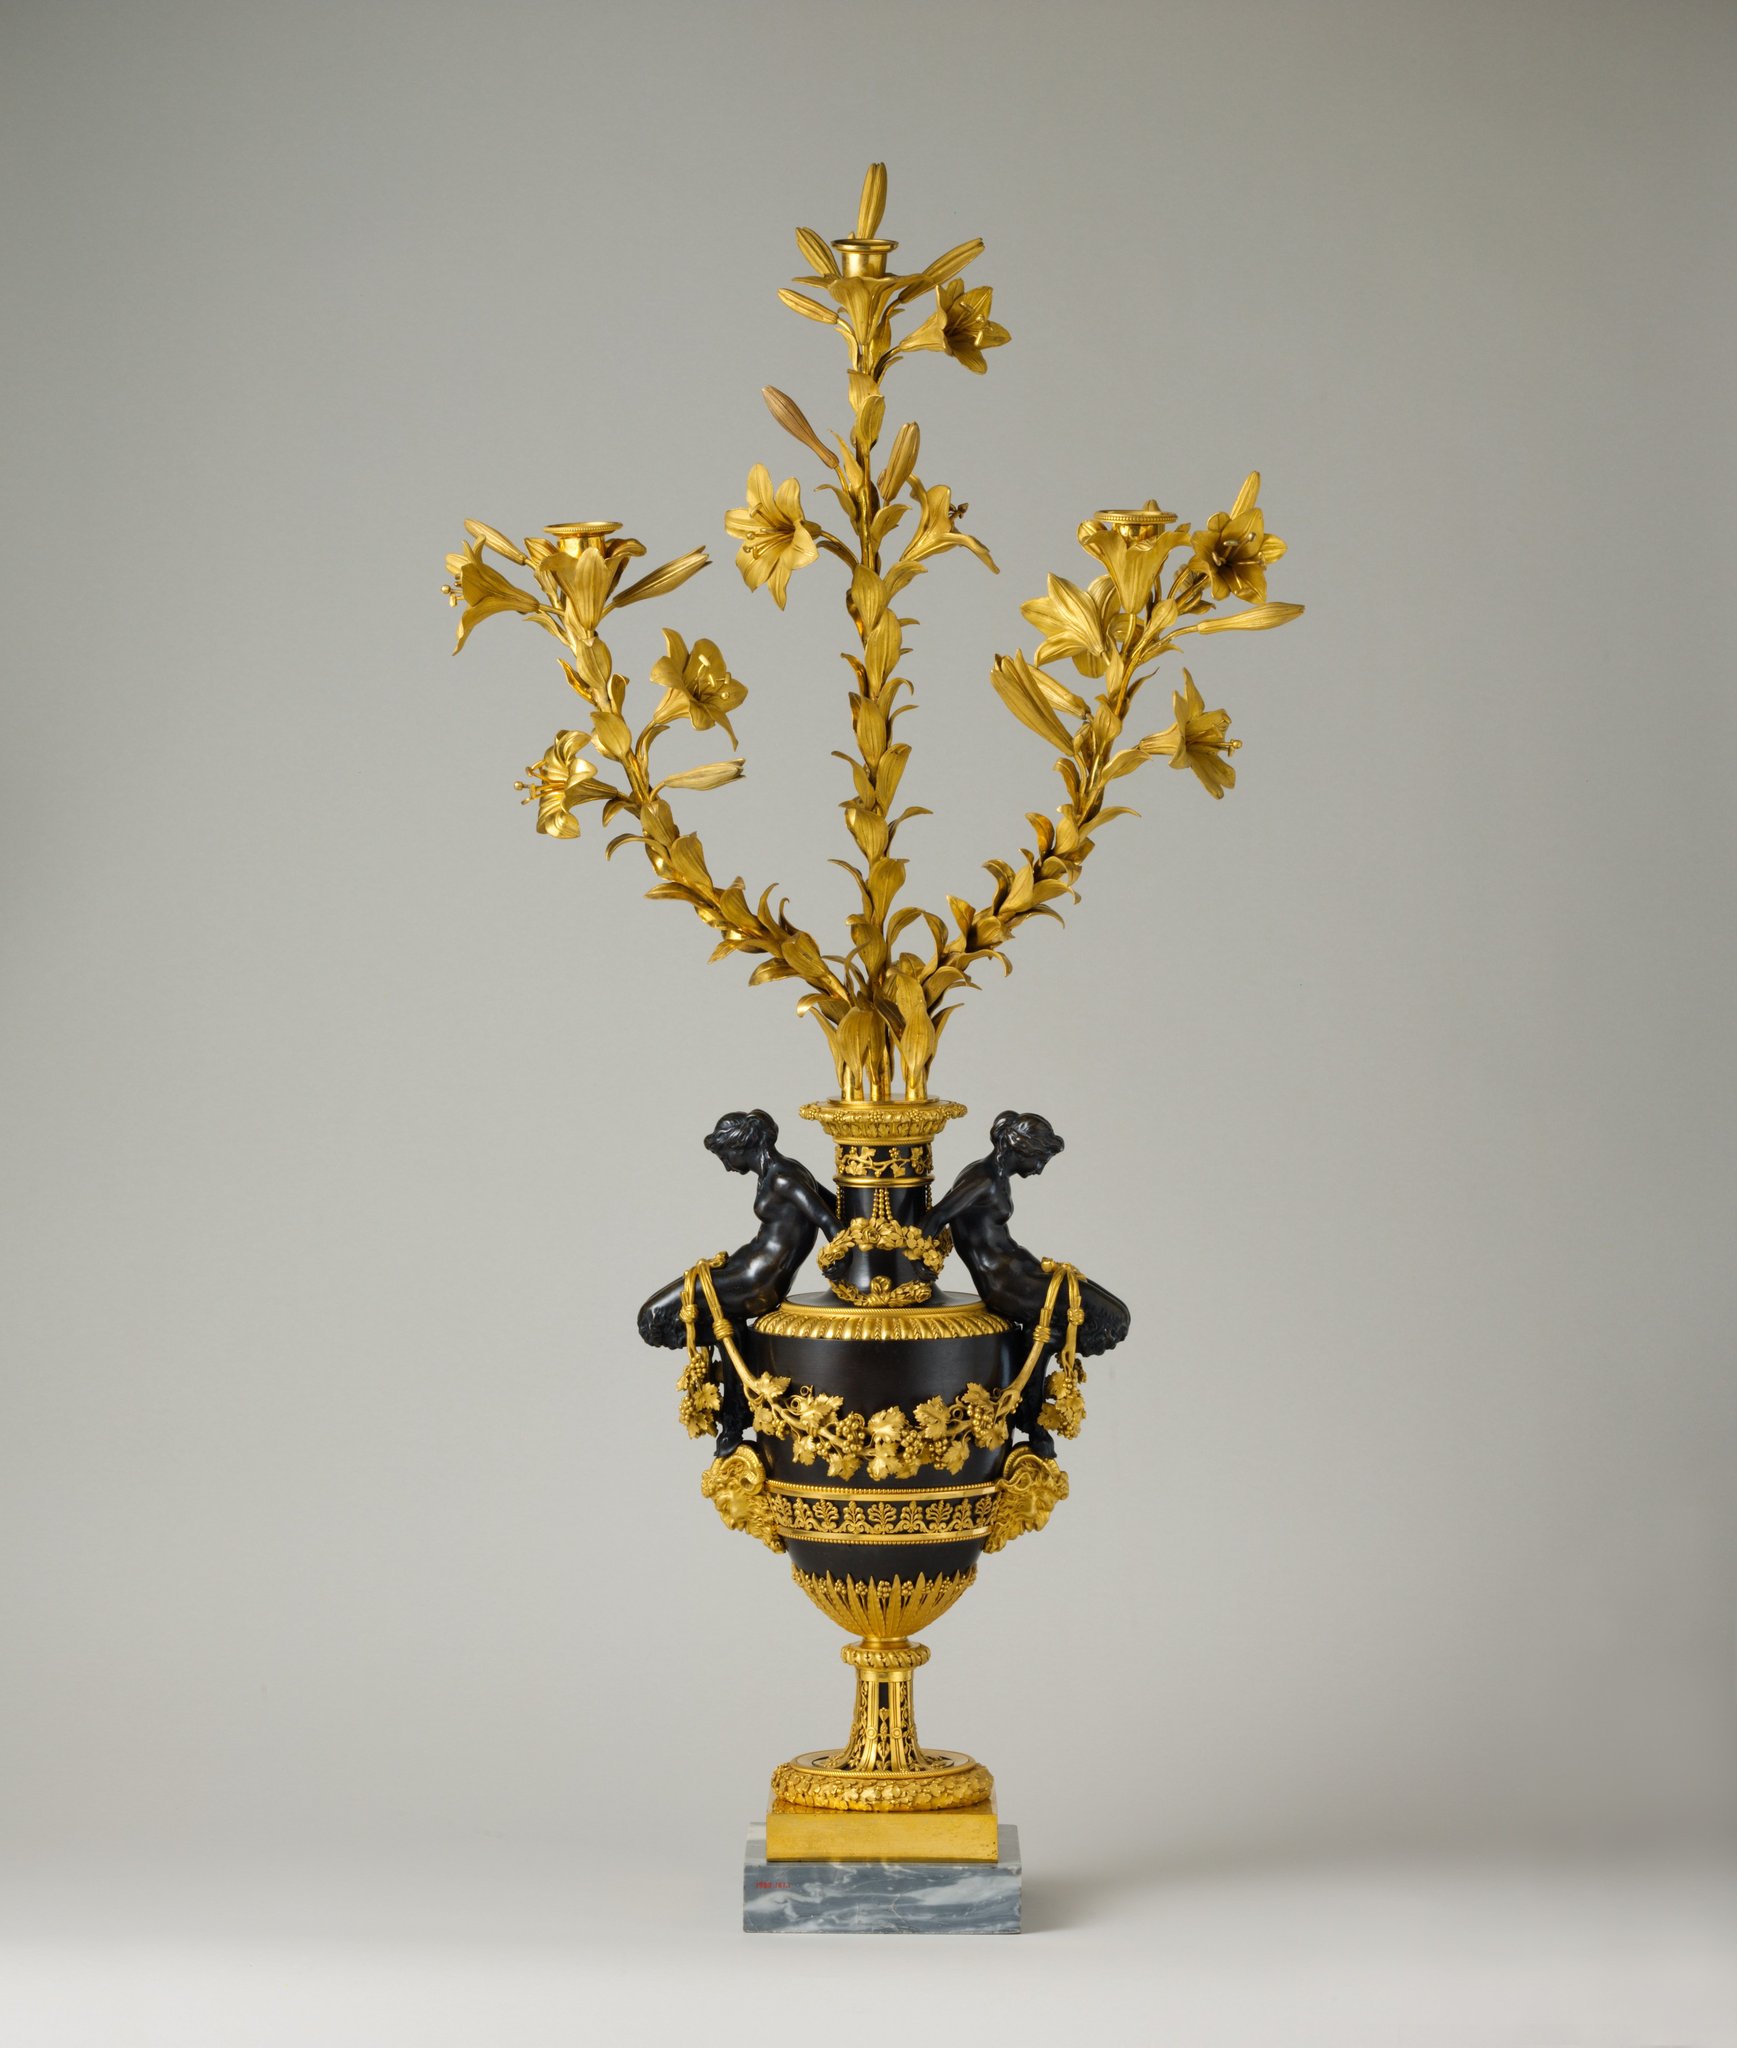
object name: candelabrum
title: Three-light candelabrum (one of a pair)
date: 1785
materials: bronze, gilt bronze, marble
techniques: enamel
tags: female nudes